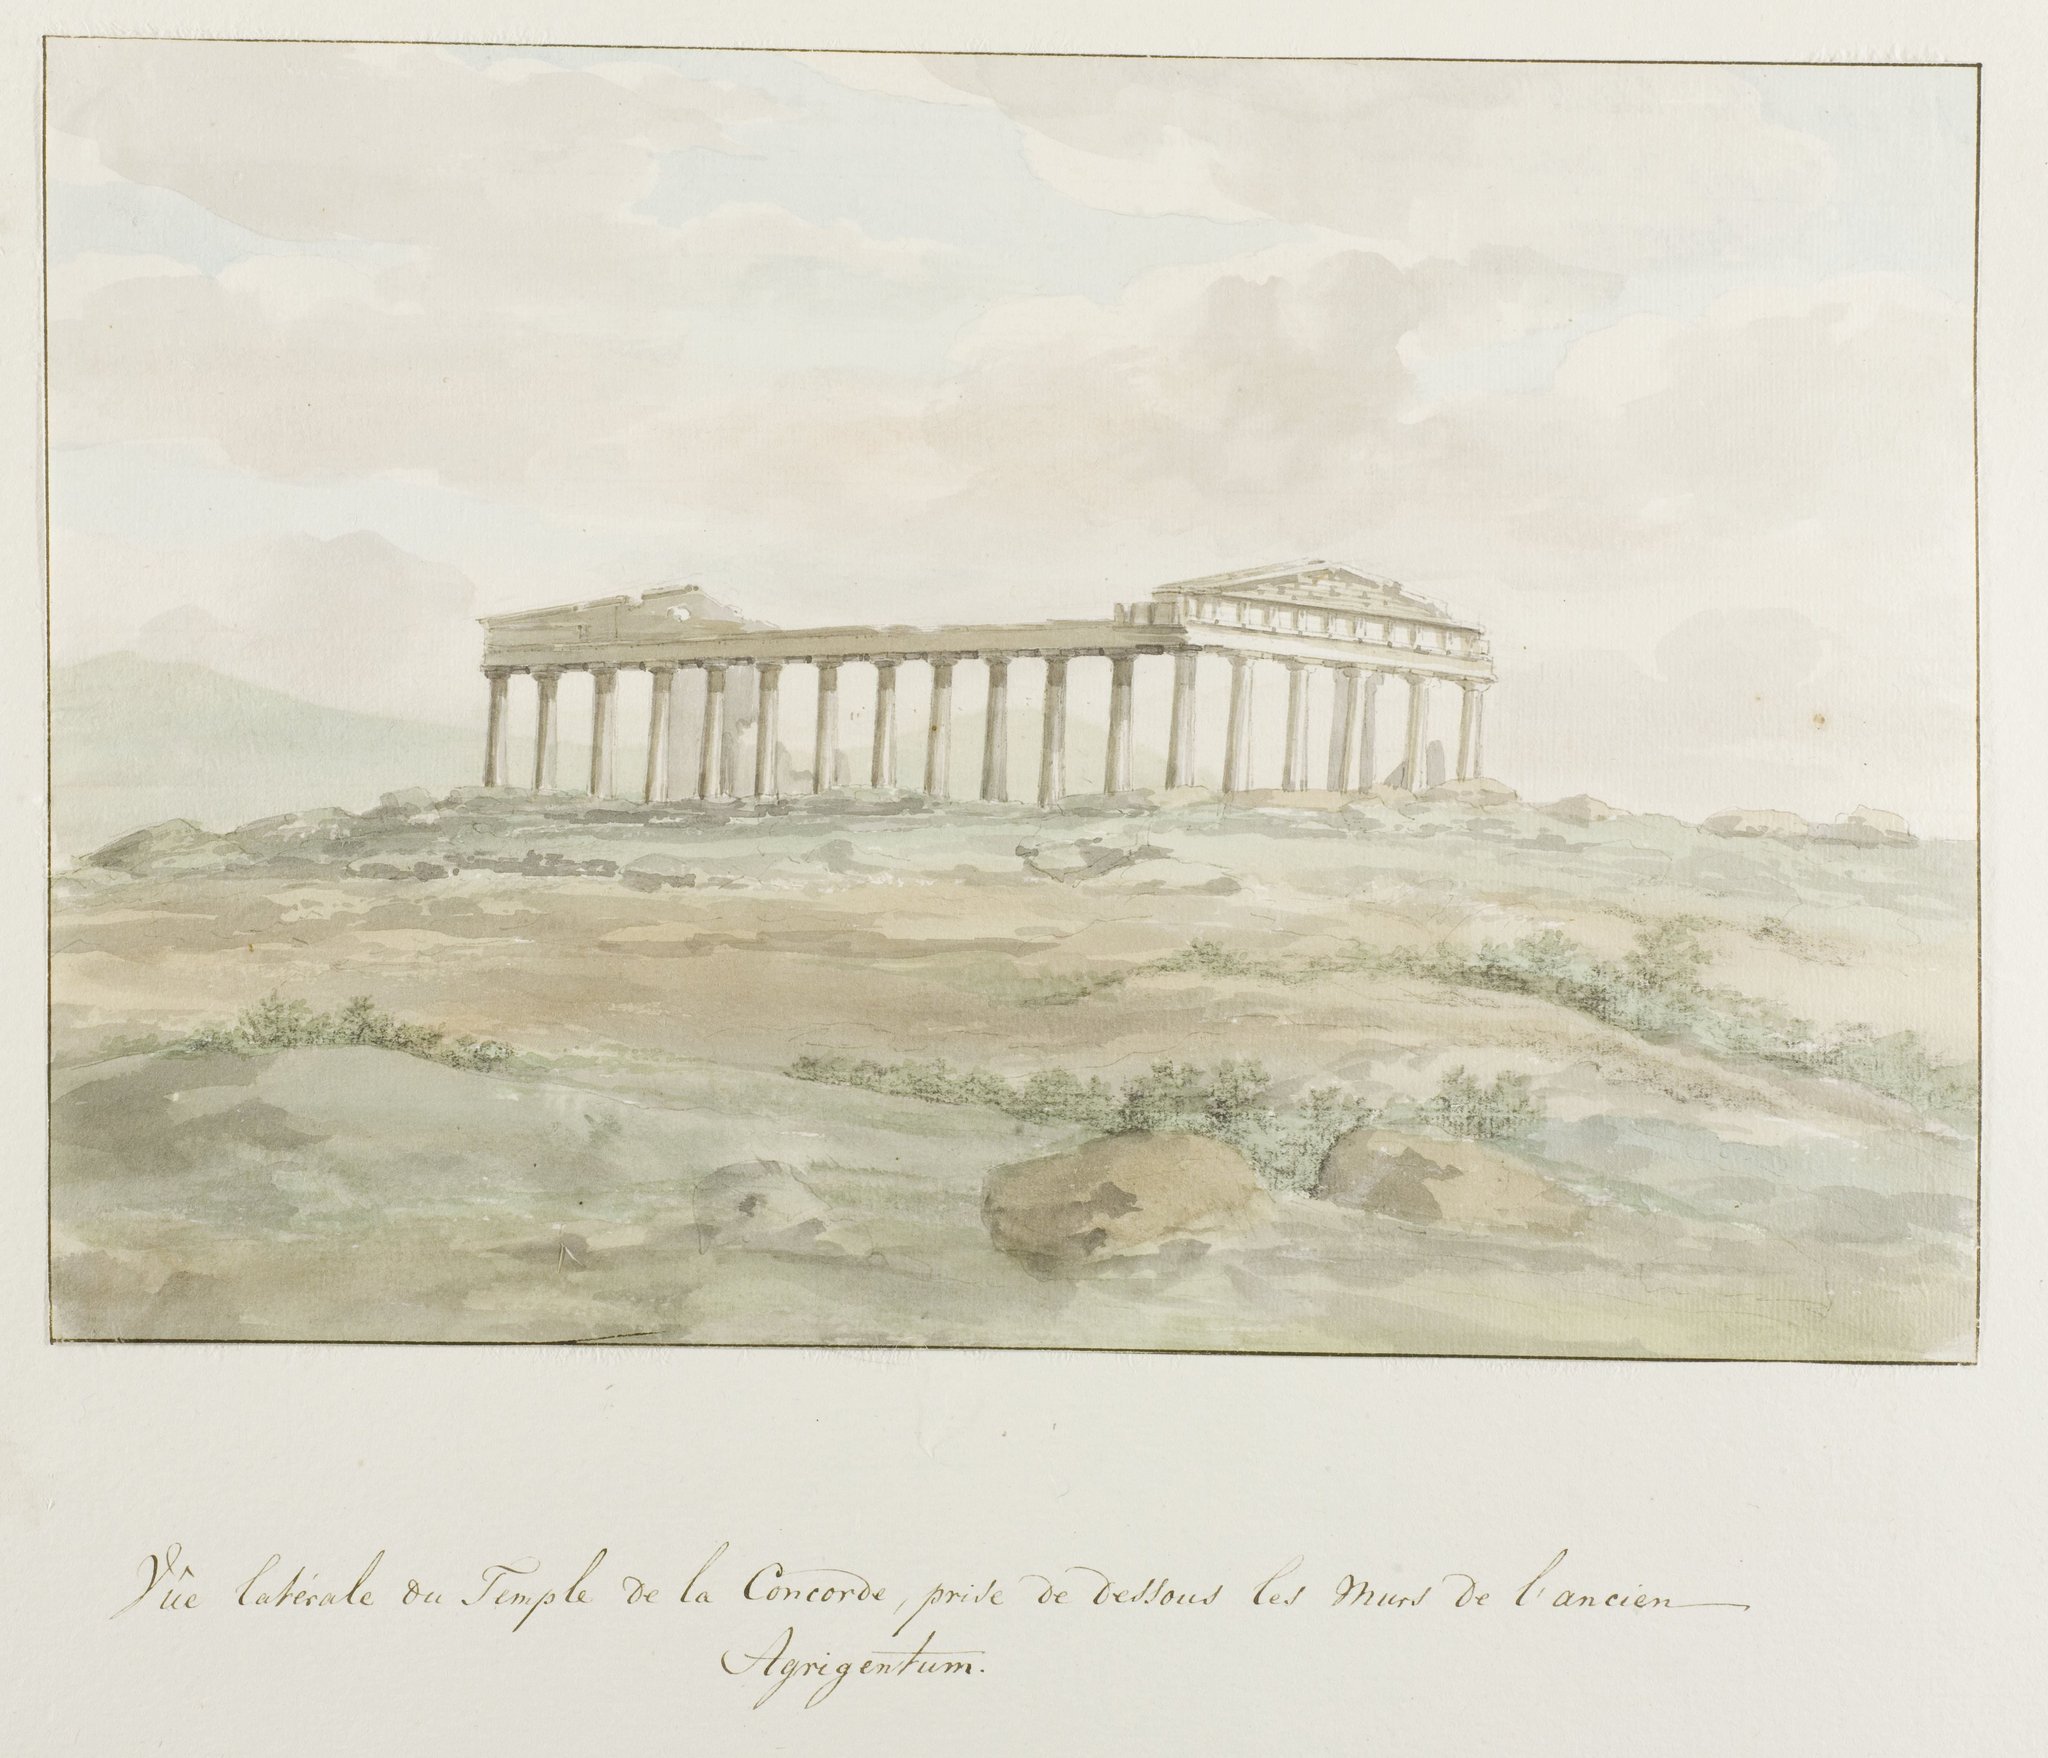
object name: drawing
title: Zijaanzicht van Concorde tempel binnen muren van oude Agrigentum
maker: louis ducros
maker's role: draughtsman, print maker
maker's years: 1748-1810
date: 1778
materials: chalk, paper, watercolor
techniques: brush, pen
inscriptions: inscription: ‘No 254 Vue latérale du Temple de la Concorde, prise de dessous les murs de l'ancien Agrigentum’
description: Tekening uit het album 'Voyage en Italie, en Sicile et à Malte', 1778.